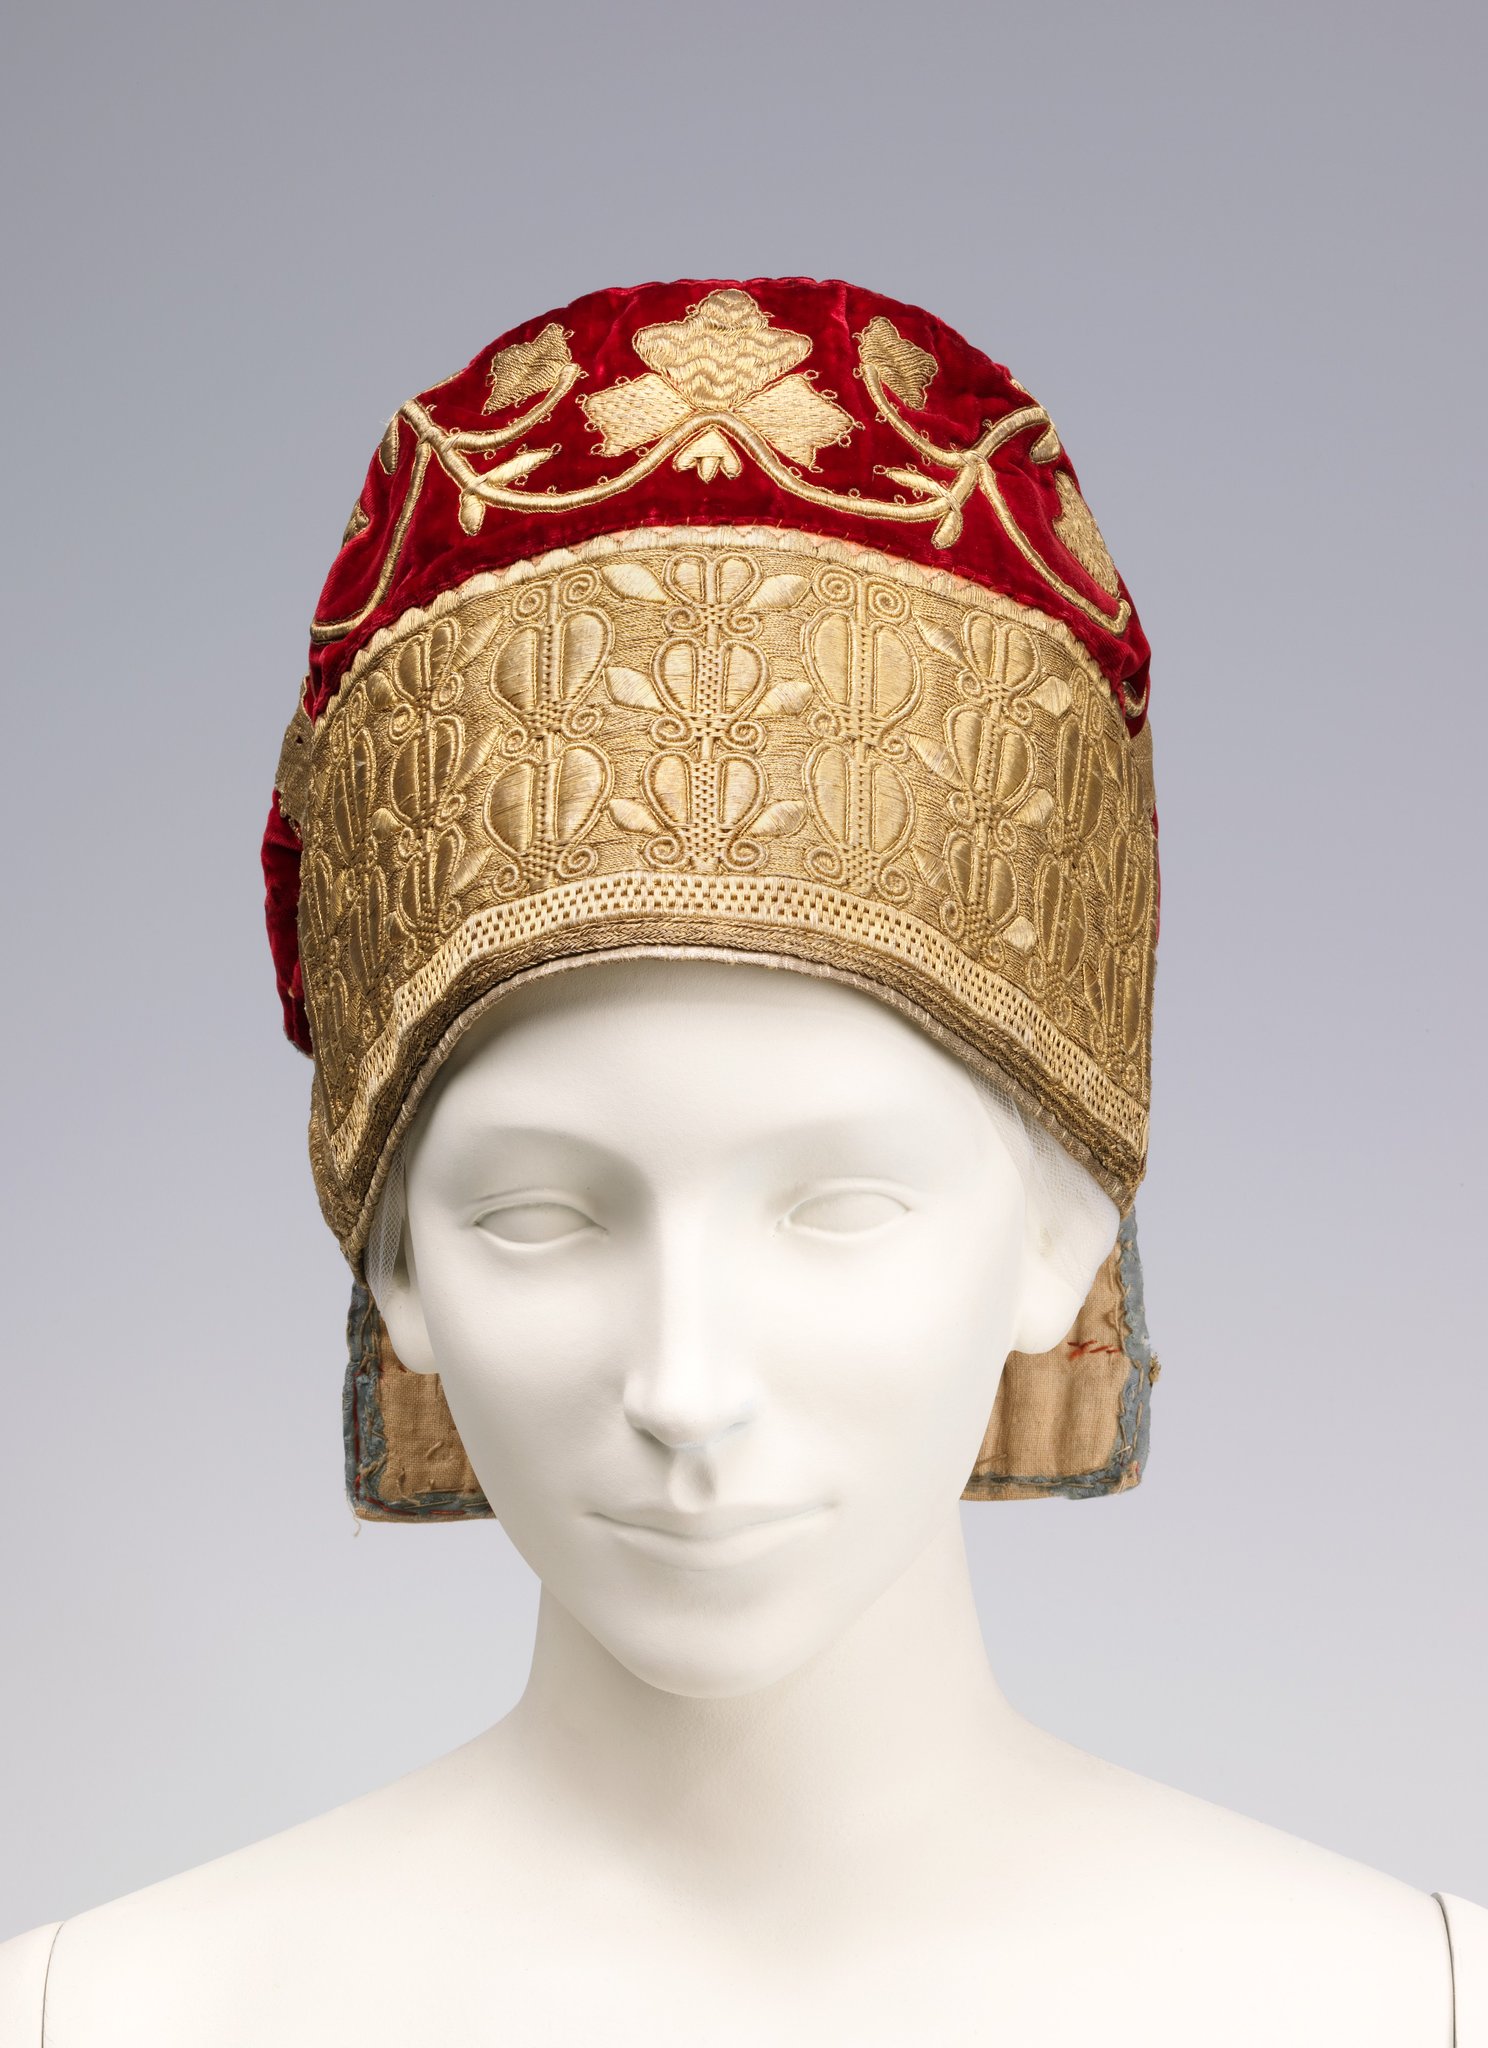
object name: hat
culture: russian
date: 1801-1900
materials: linen, metal, silk